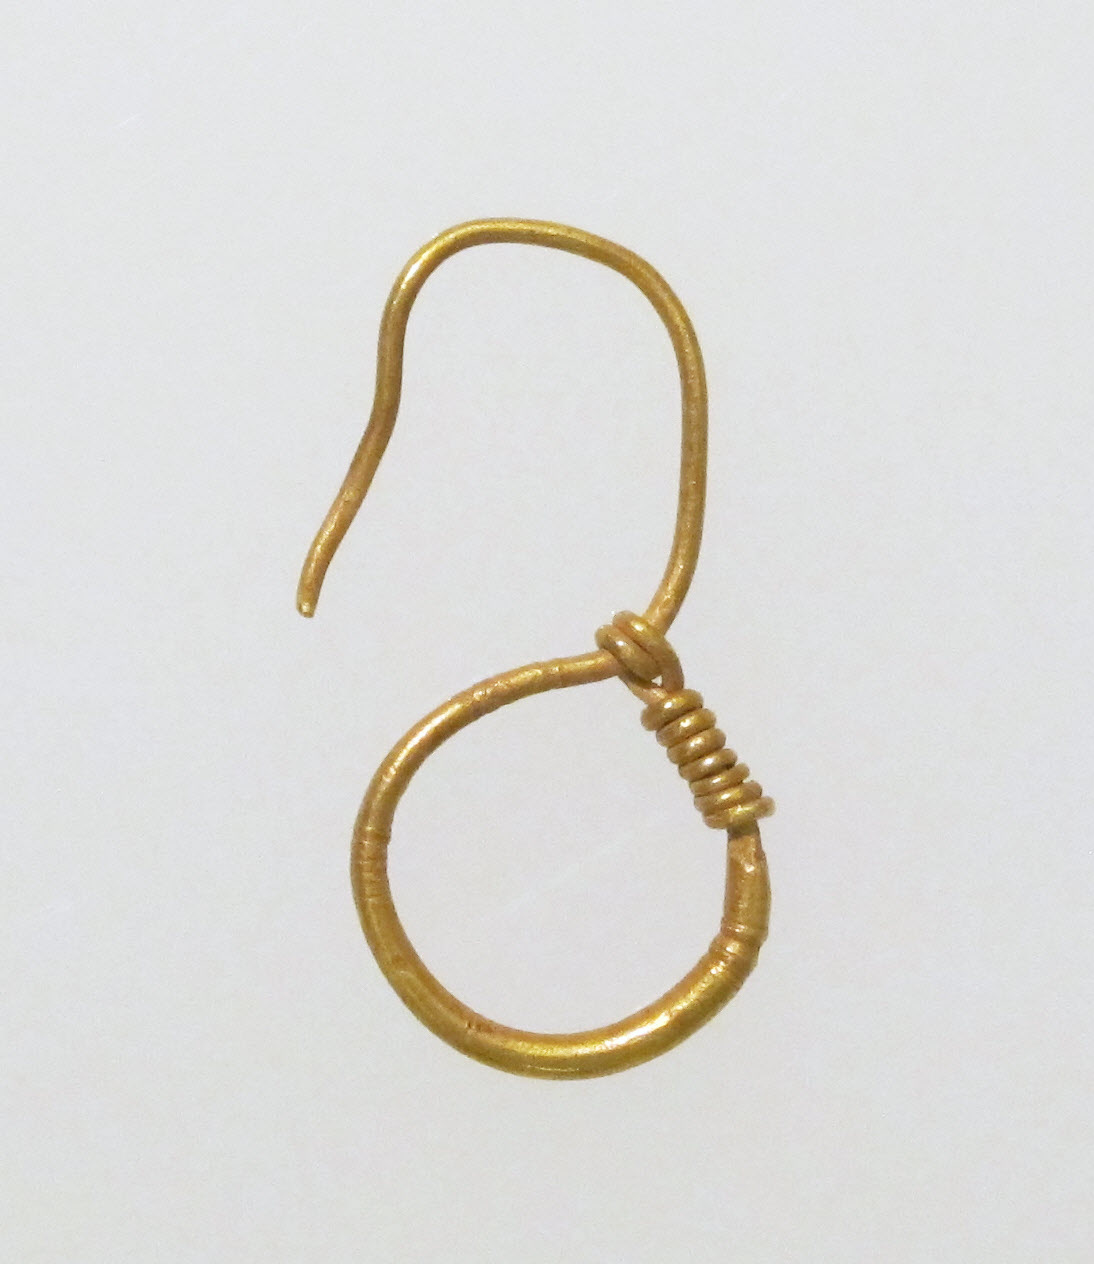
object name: earring, delta shaped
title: Earring, delta-shaped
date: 7000 BCE-330 CE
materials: gold